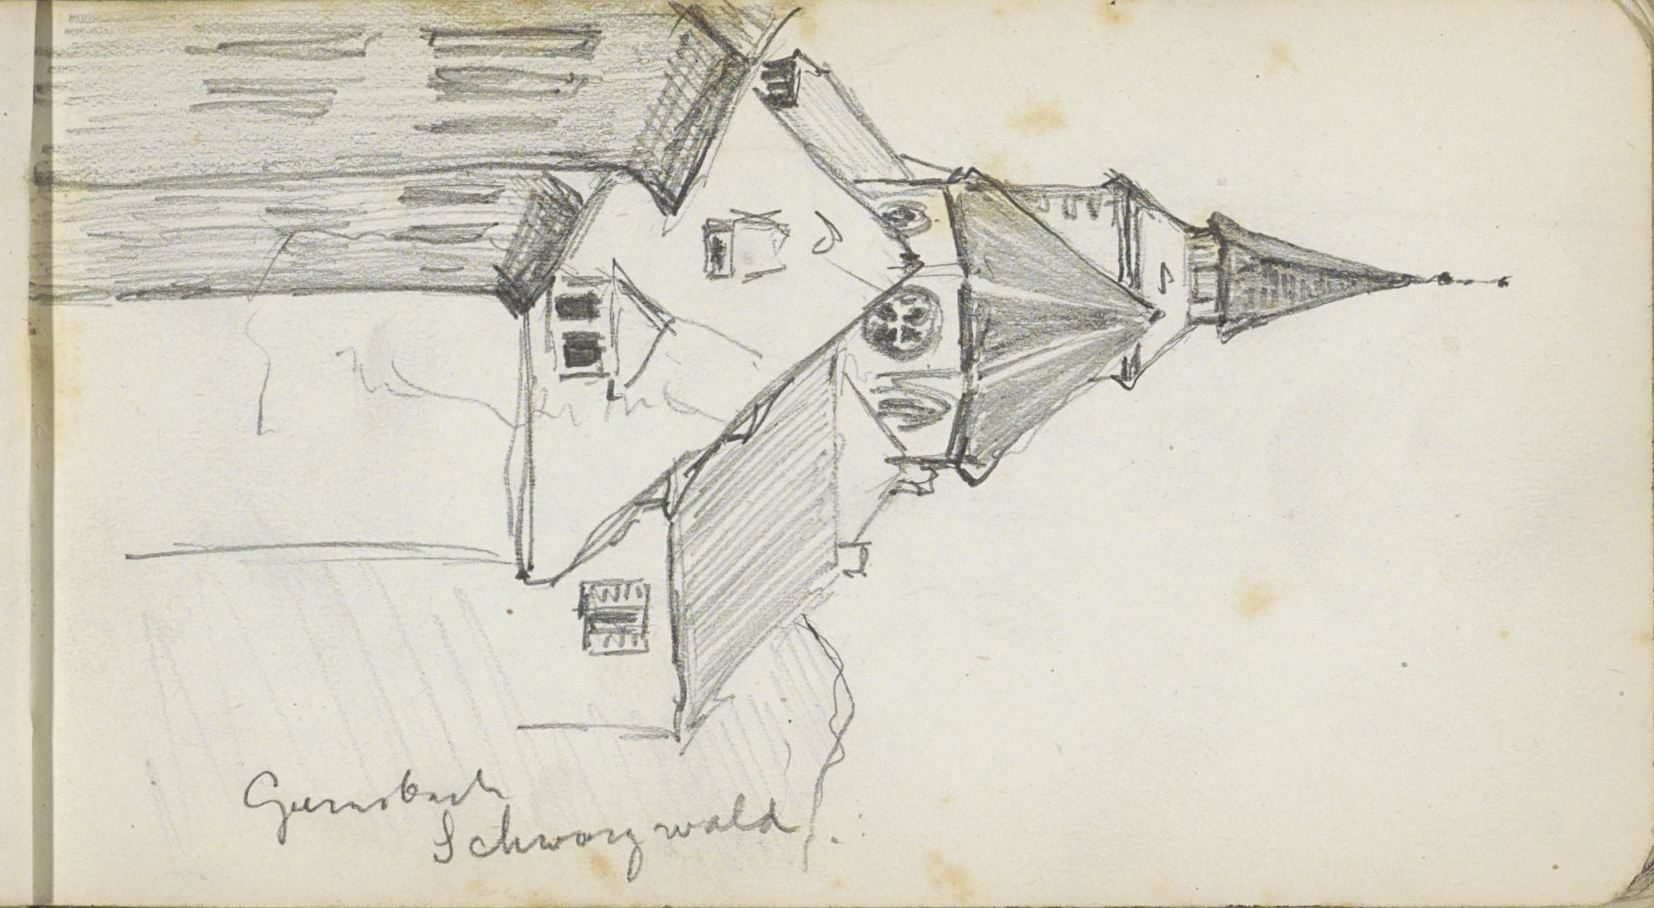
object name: sketchbook leaf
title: Kerk te Gernsbach in het Schwarzwald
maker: geo poggenbeek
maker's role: draughtsman, painter, print maker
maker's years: 1853-1903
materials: paper, pencil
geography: gernsbach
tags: church (exterior)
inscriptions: annotation: ‘Gernsbach/ Schwarzwald.’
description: Blad 35 recto uit een schetsboek met 69 bladen.